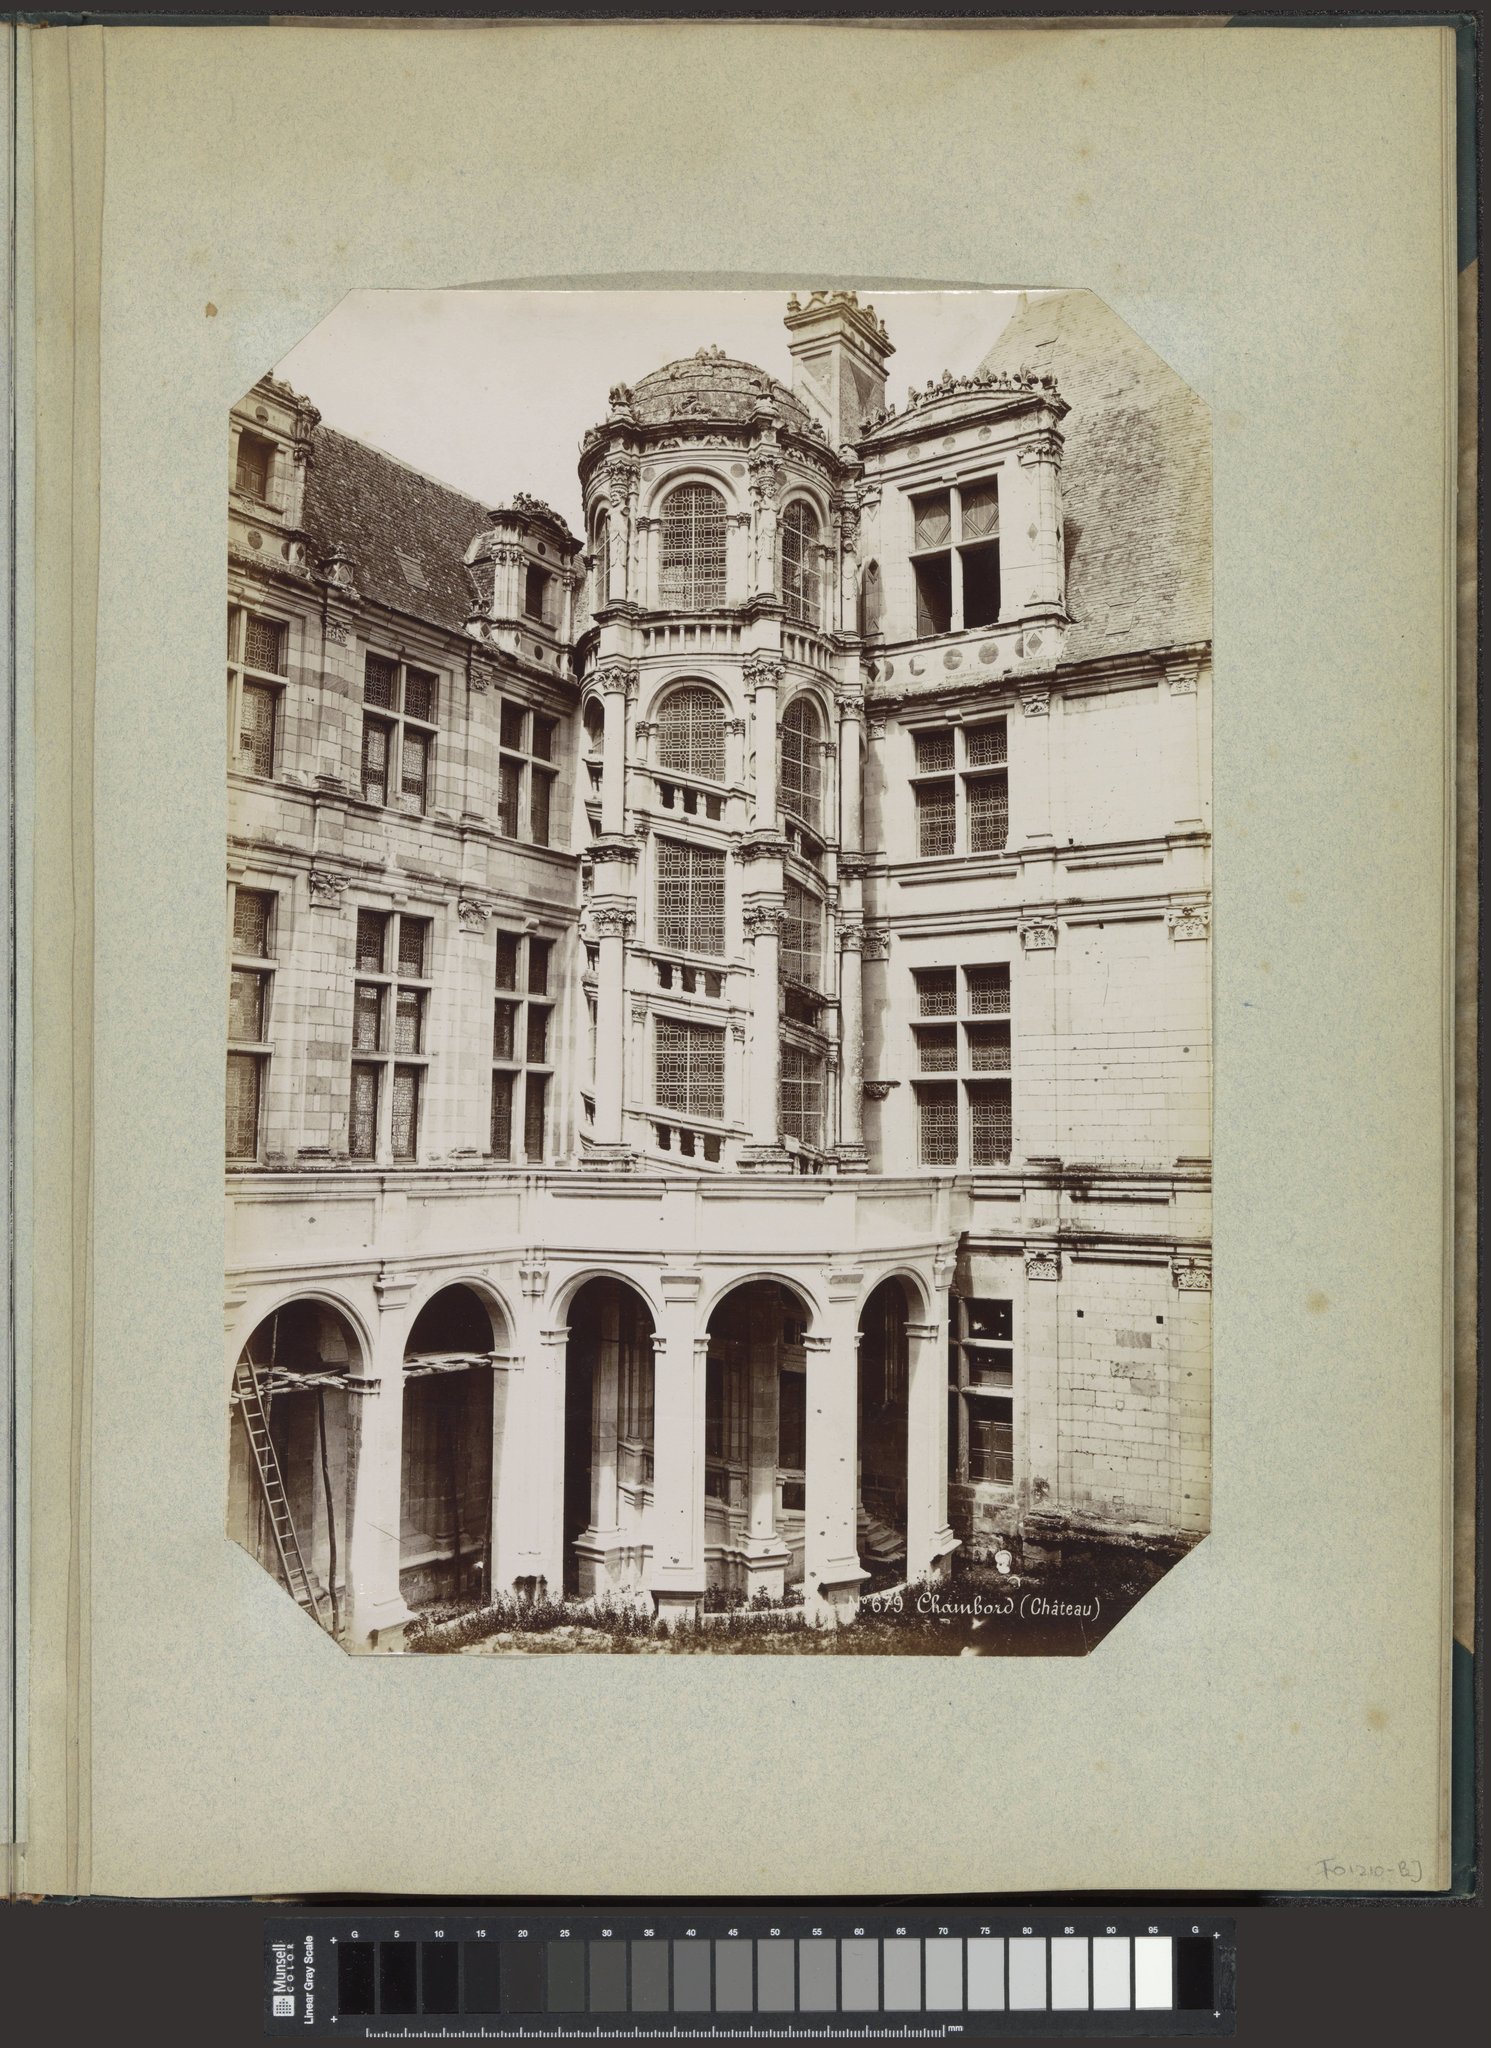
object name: photograph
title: Chambord (Château)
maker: séraphin-médéric mieusement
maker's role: fotograaf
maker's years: 1840-1905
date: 1880-1900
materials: photographic support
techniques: albumen print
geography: chambord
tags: castle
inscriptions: inscription: ‘Monuments Historiques’, number: ‘679’, name: ‘Mieusement photographe’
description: Onderdeel van Fotoalbum met opnames van monumenten in Frankrijk.